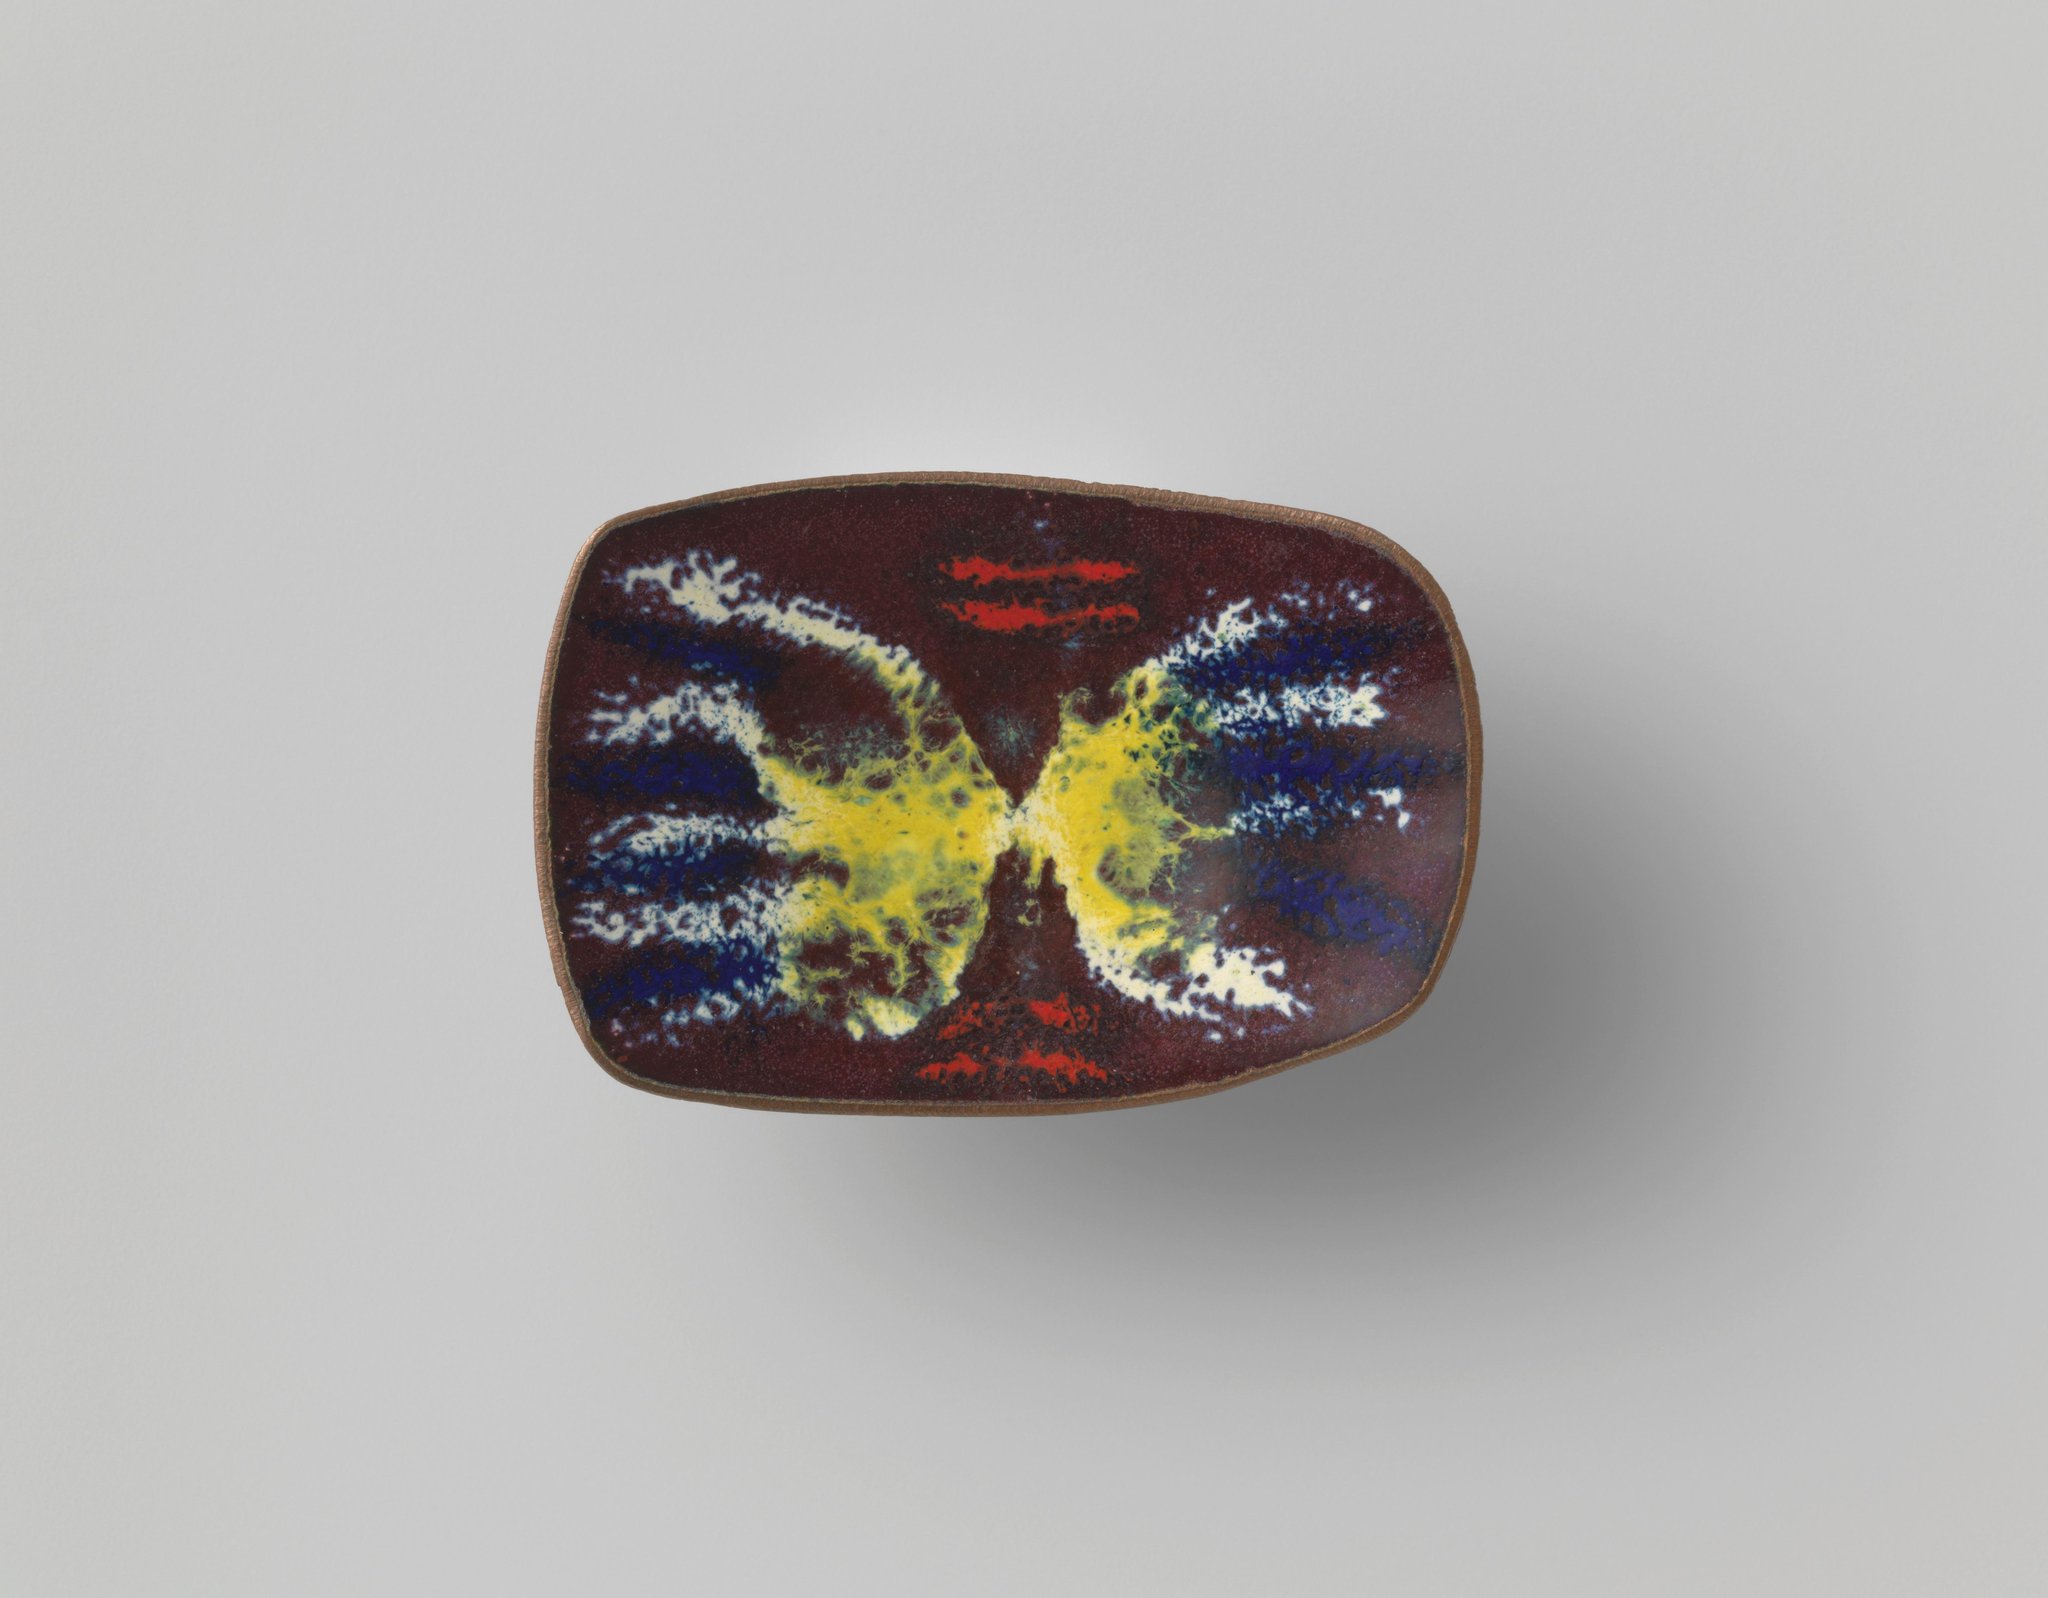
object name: brooch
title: Concave broche van email op koper met abstracte voorstelling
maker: Anonymous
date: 1950-1960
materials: copper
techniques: enameling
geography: europe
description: Concave broche van email op koper voorzien van een haaksluiting. De broche heeft de vorm van een rechthoek met afgeronde hoeken. Aan de voorzijde een abstracte decoratie in de primaire kleuren en wit op een bruine grond.